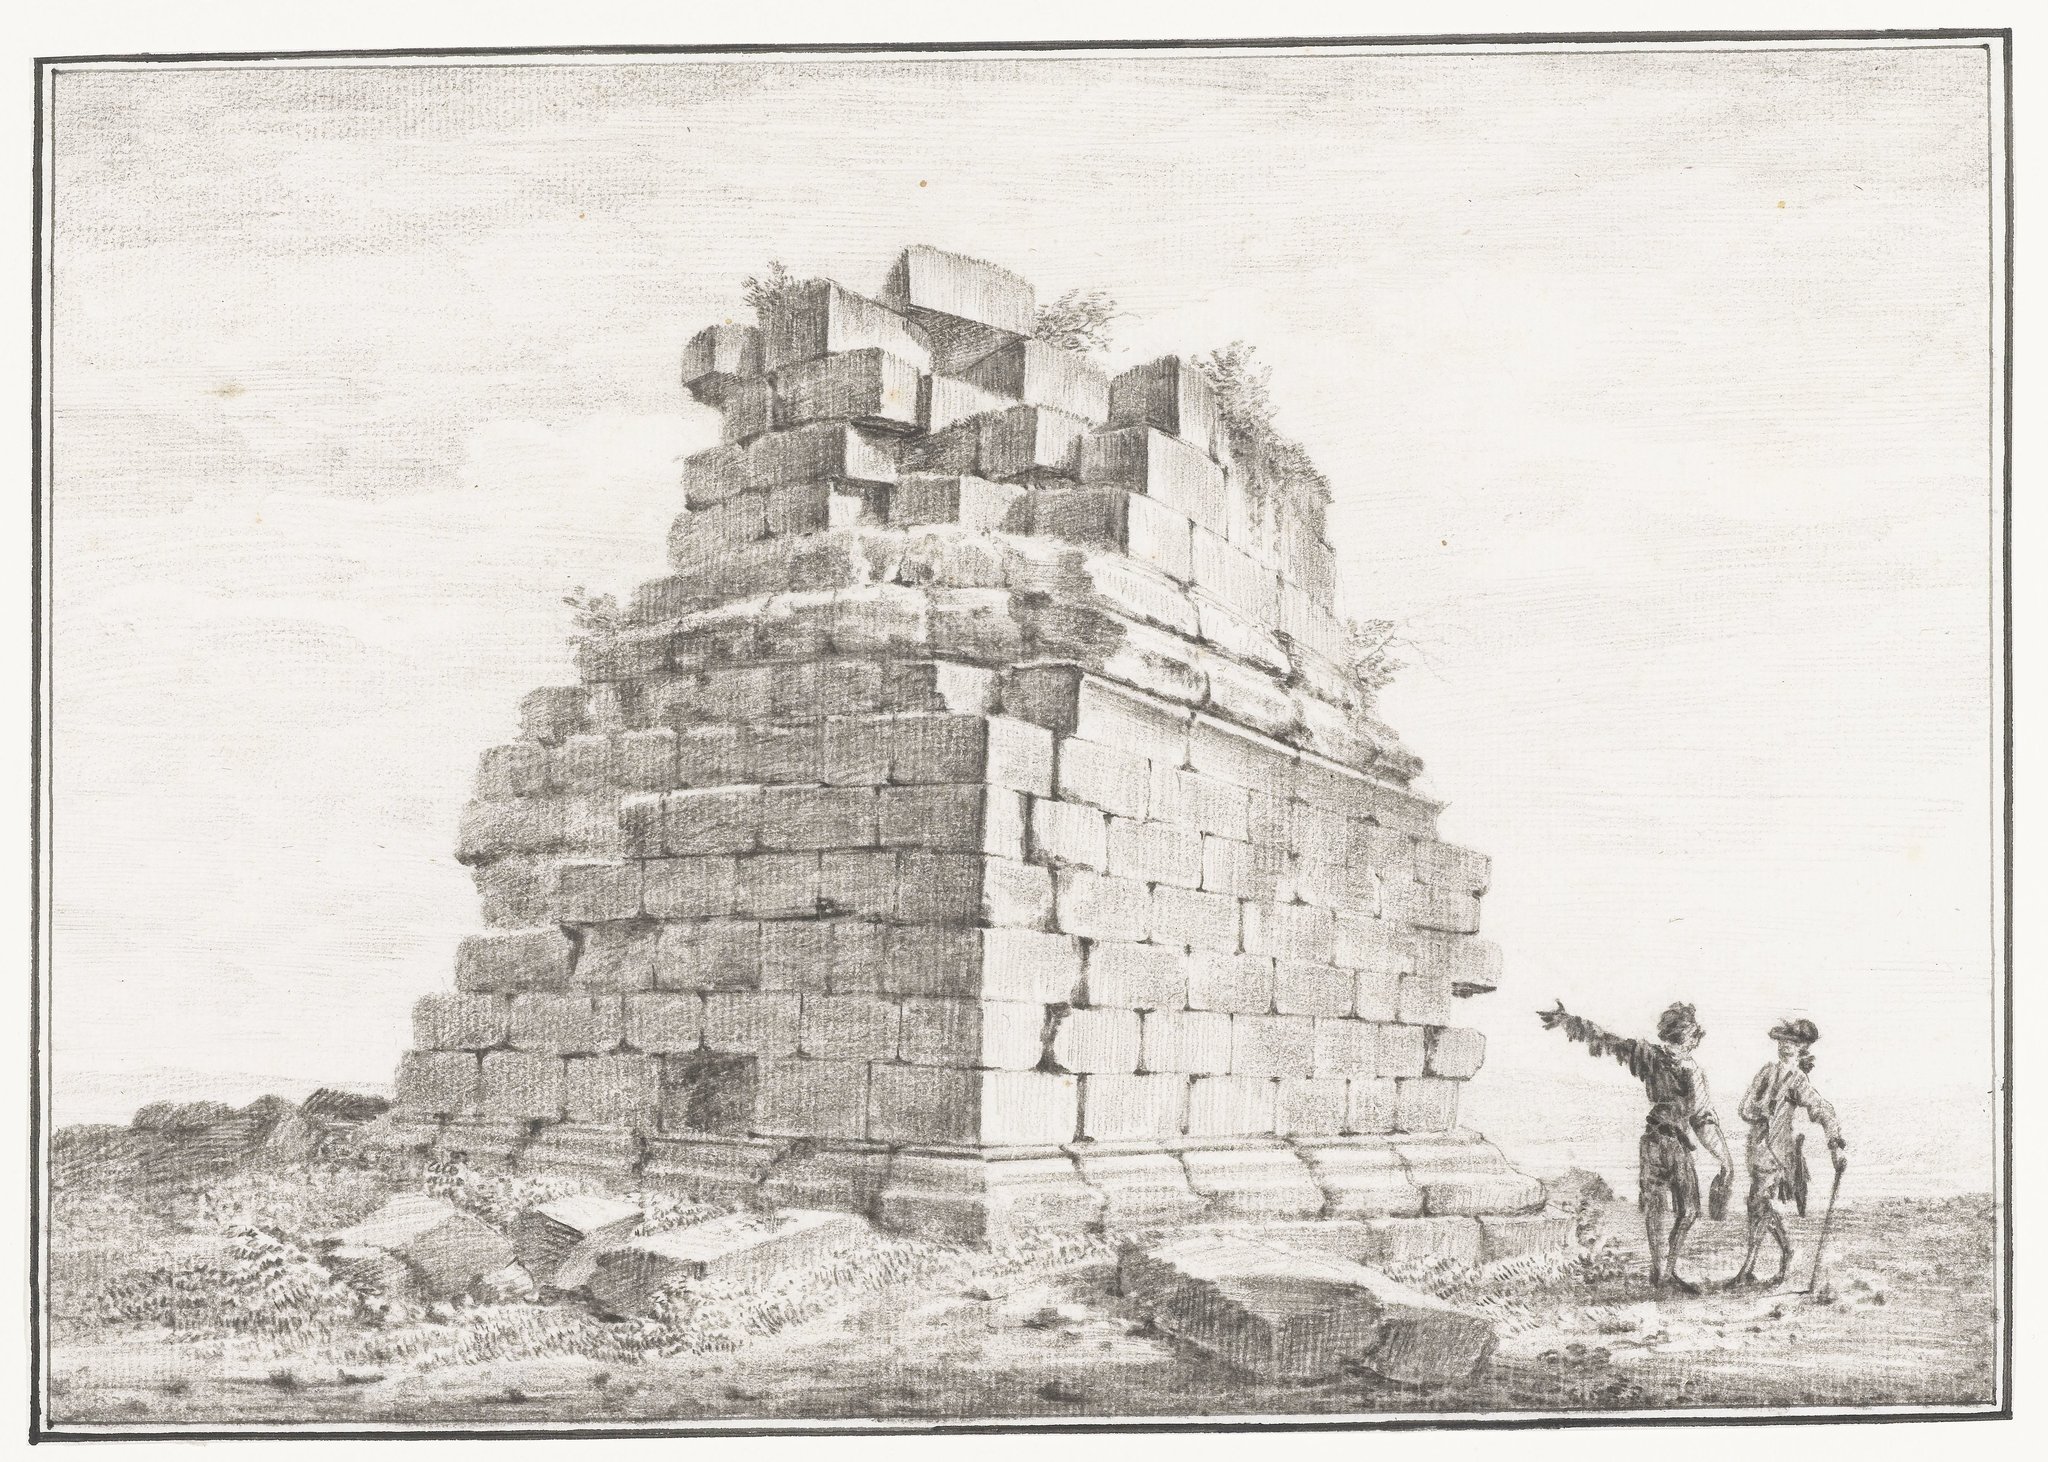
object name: drawing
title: Voyage en Italie, en Sicile et à Malte - 1778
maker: louis mayer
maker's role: draughtsman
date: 1778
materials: chalk, paper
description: Tekening uit het album 'Voyage en Italie, en Sicile et à Malte', 1778.